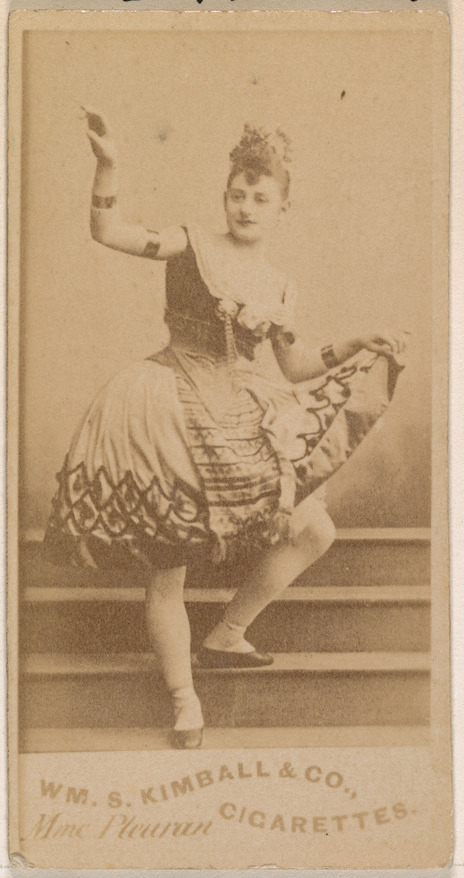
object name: photograph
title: Mme. Pleuran, from the Actresses series (N203) issued by Wm. S. Kimball & Co.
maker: william s. kimball & company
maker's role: publisher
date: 1889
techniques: color lithograph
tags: portraits,women,actresses